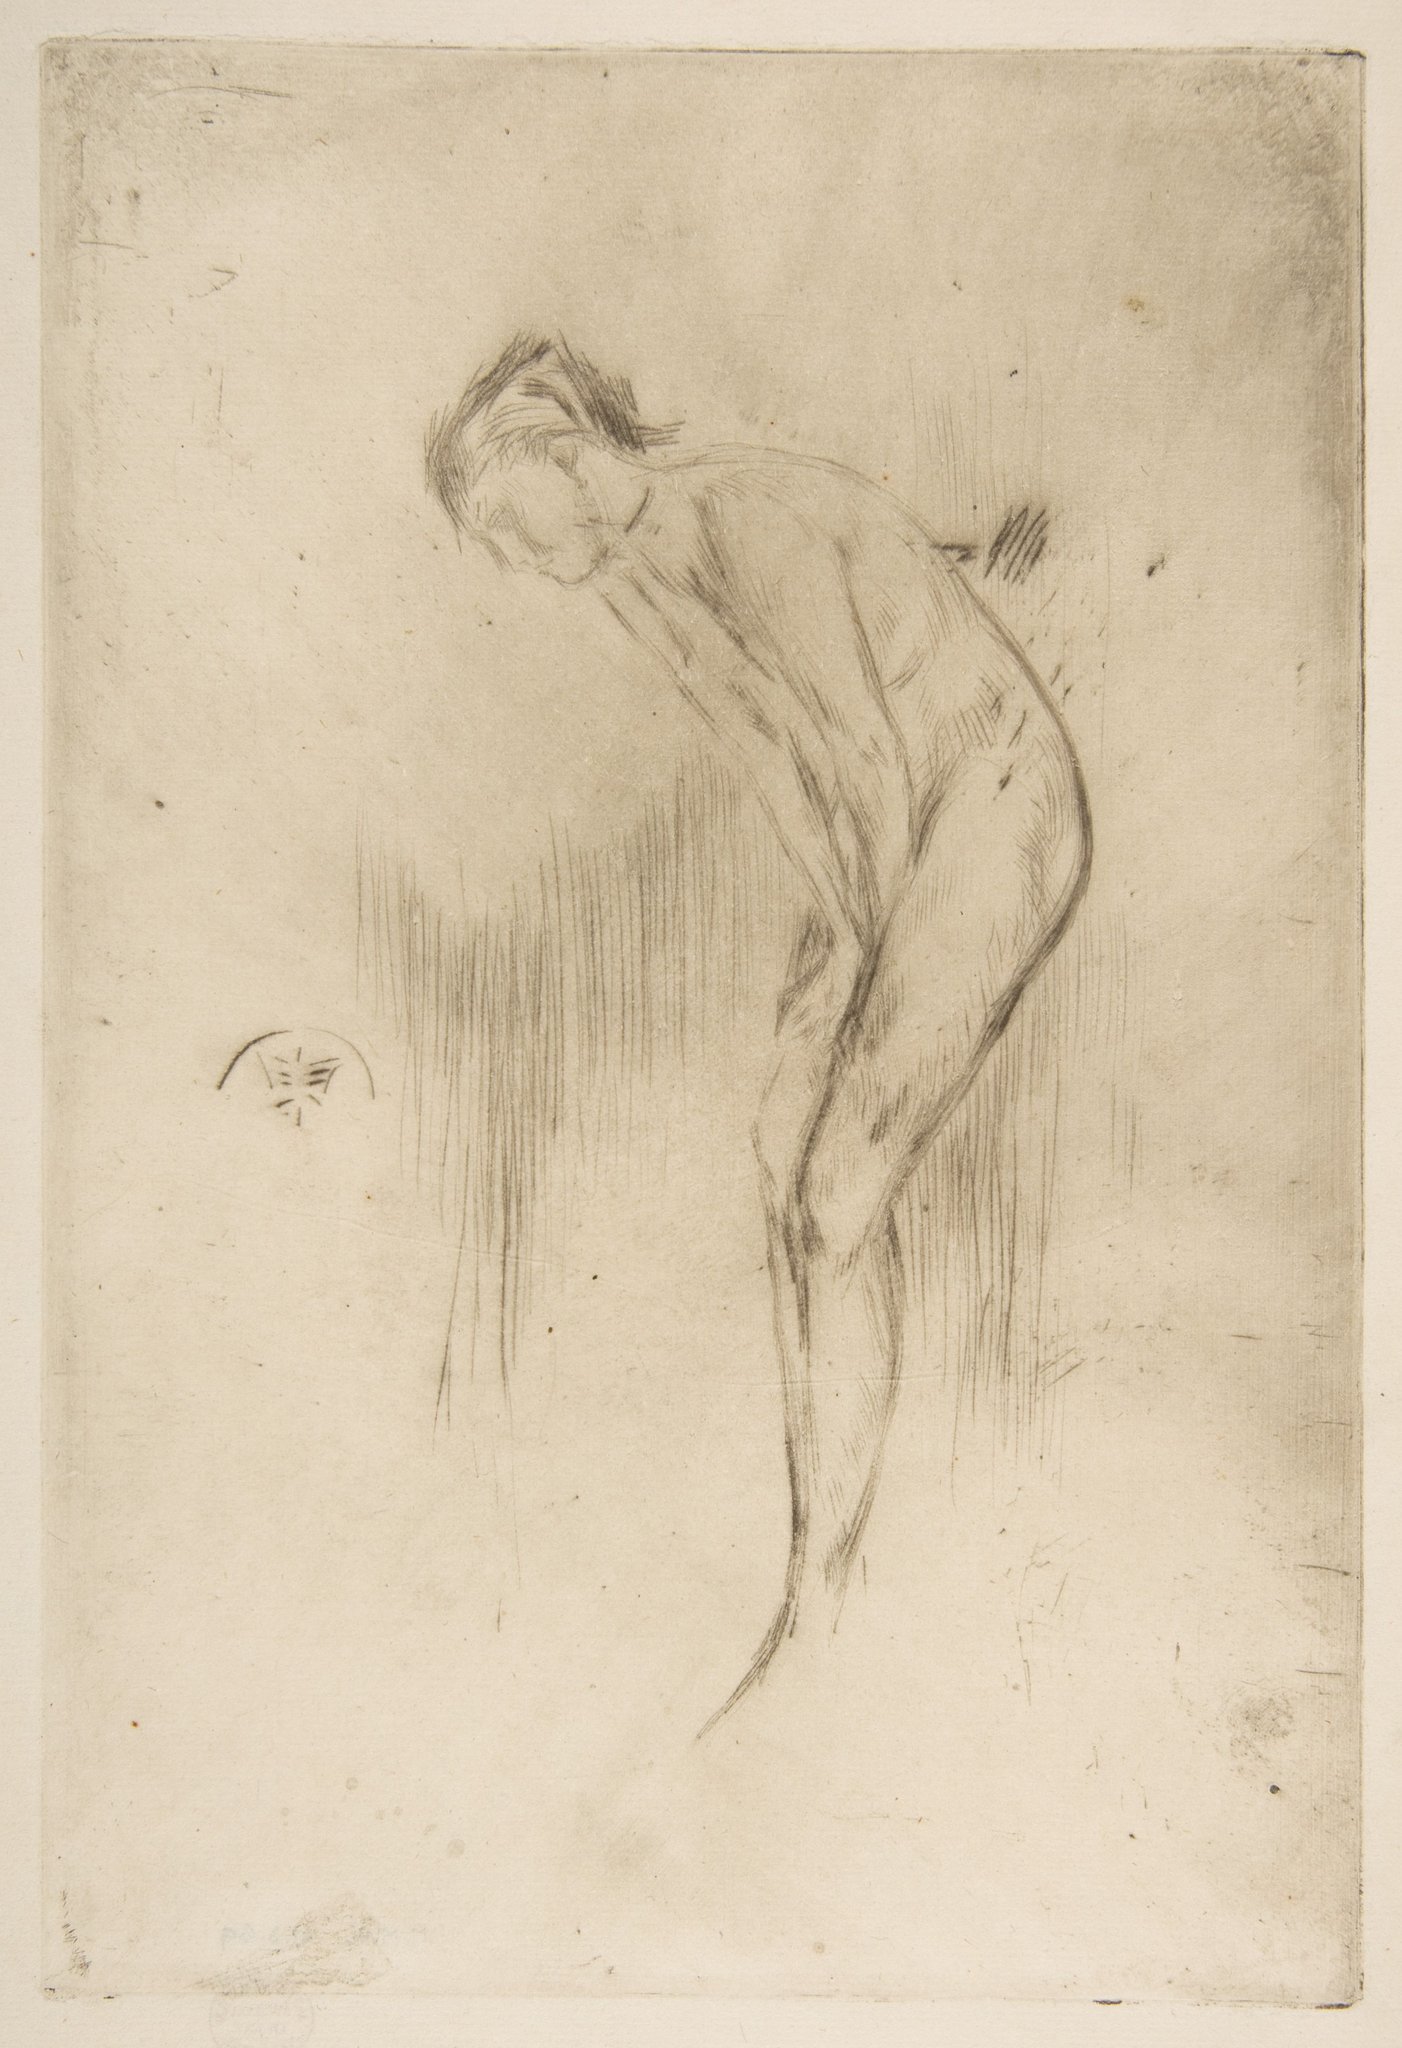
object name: print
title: Tillie: a Model (Tillie Gilchrist)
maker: james mcneill whistler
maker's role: artist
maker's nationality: american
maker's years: 1834-1903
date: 1873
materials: ink, paper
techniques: drypoint, printing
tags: male nudes